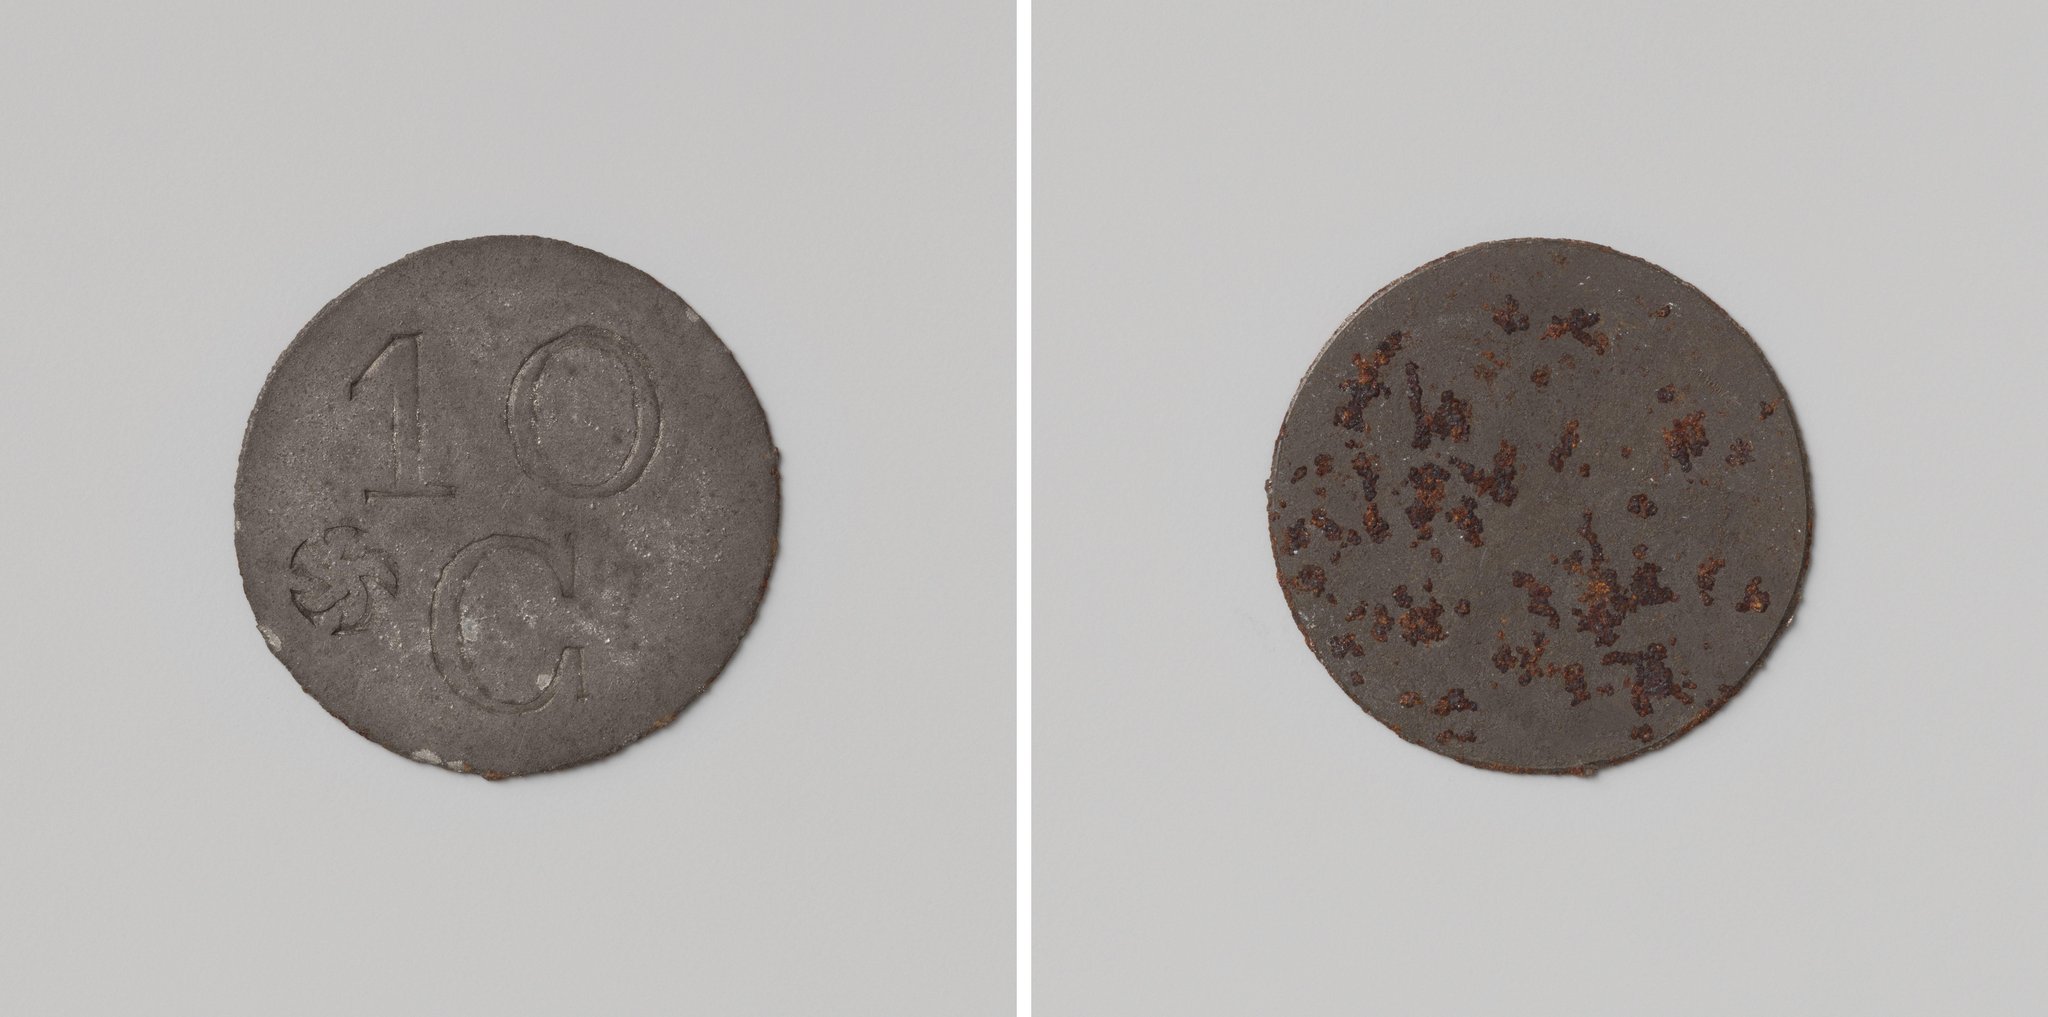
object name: tien cent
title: Strafgevangenis te 's-Hertogenbosch, huismunt ter waarde van tien cent. In de periode 1824-1830 in 's-Hertogenbosch gebruikt, daarna in de periode 1831-1834 in Gouda en Woerden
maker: hendrikus wansink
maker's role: blikslager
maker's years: 1778-1869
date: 1824-1834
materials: metal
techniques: striking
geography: den bosch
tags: den bosch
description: eenzijdige betaalpenning. Voorzijde: waardeaanduiding; rechts onder: vijfbladige rozet. Keerzijde: blanco